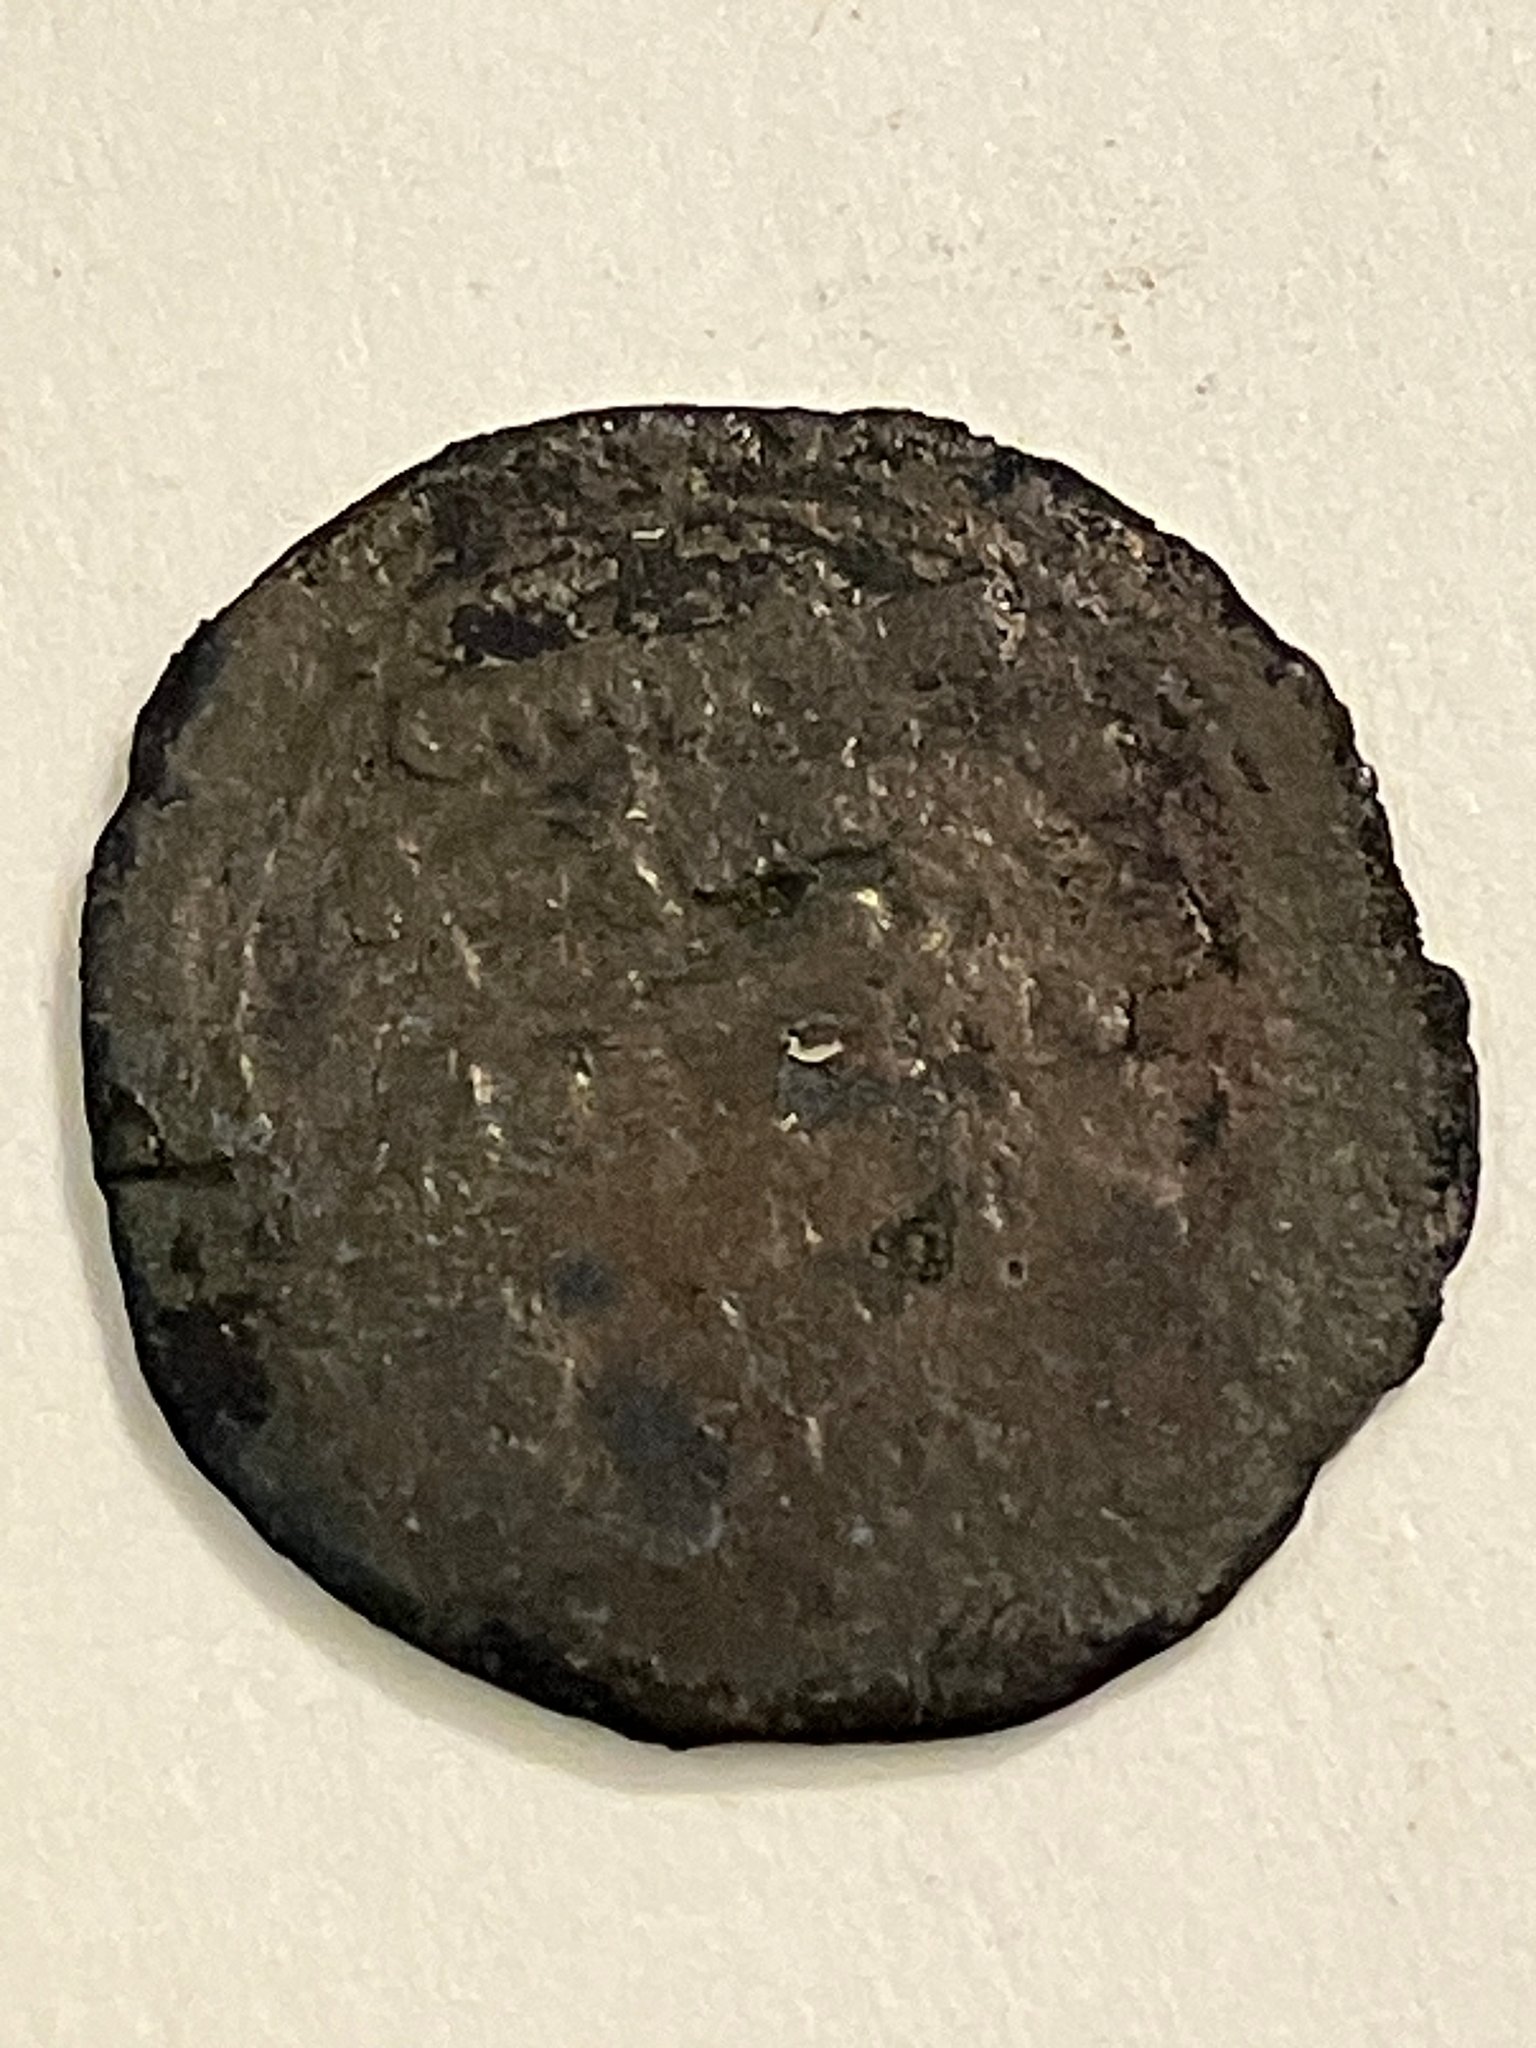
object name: coin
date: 1030-1074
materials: copper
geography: iran